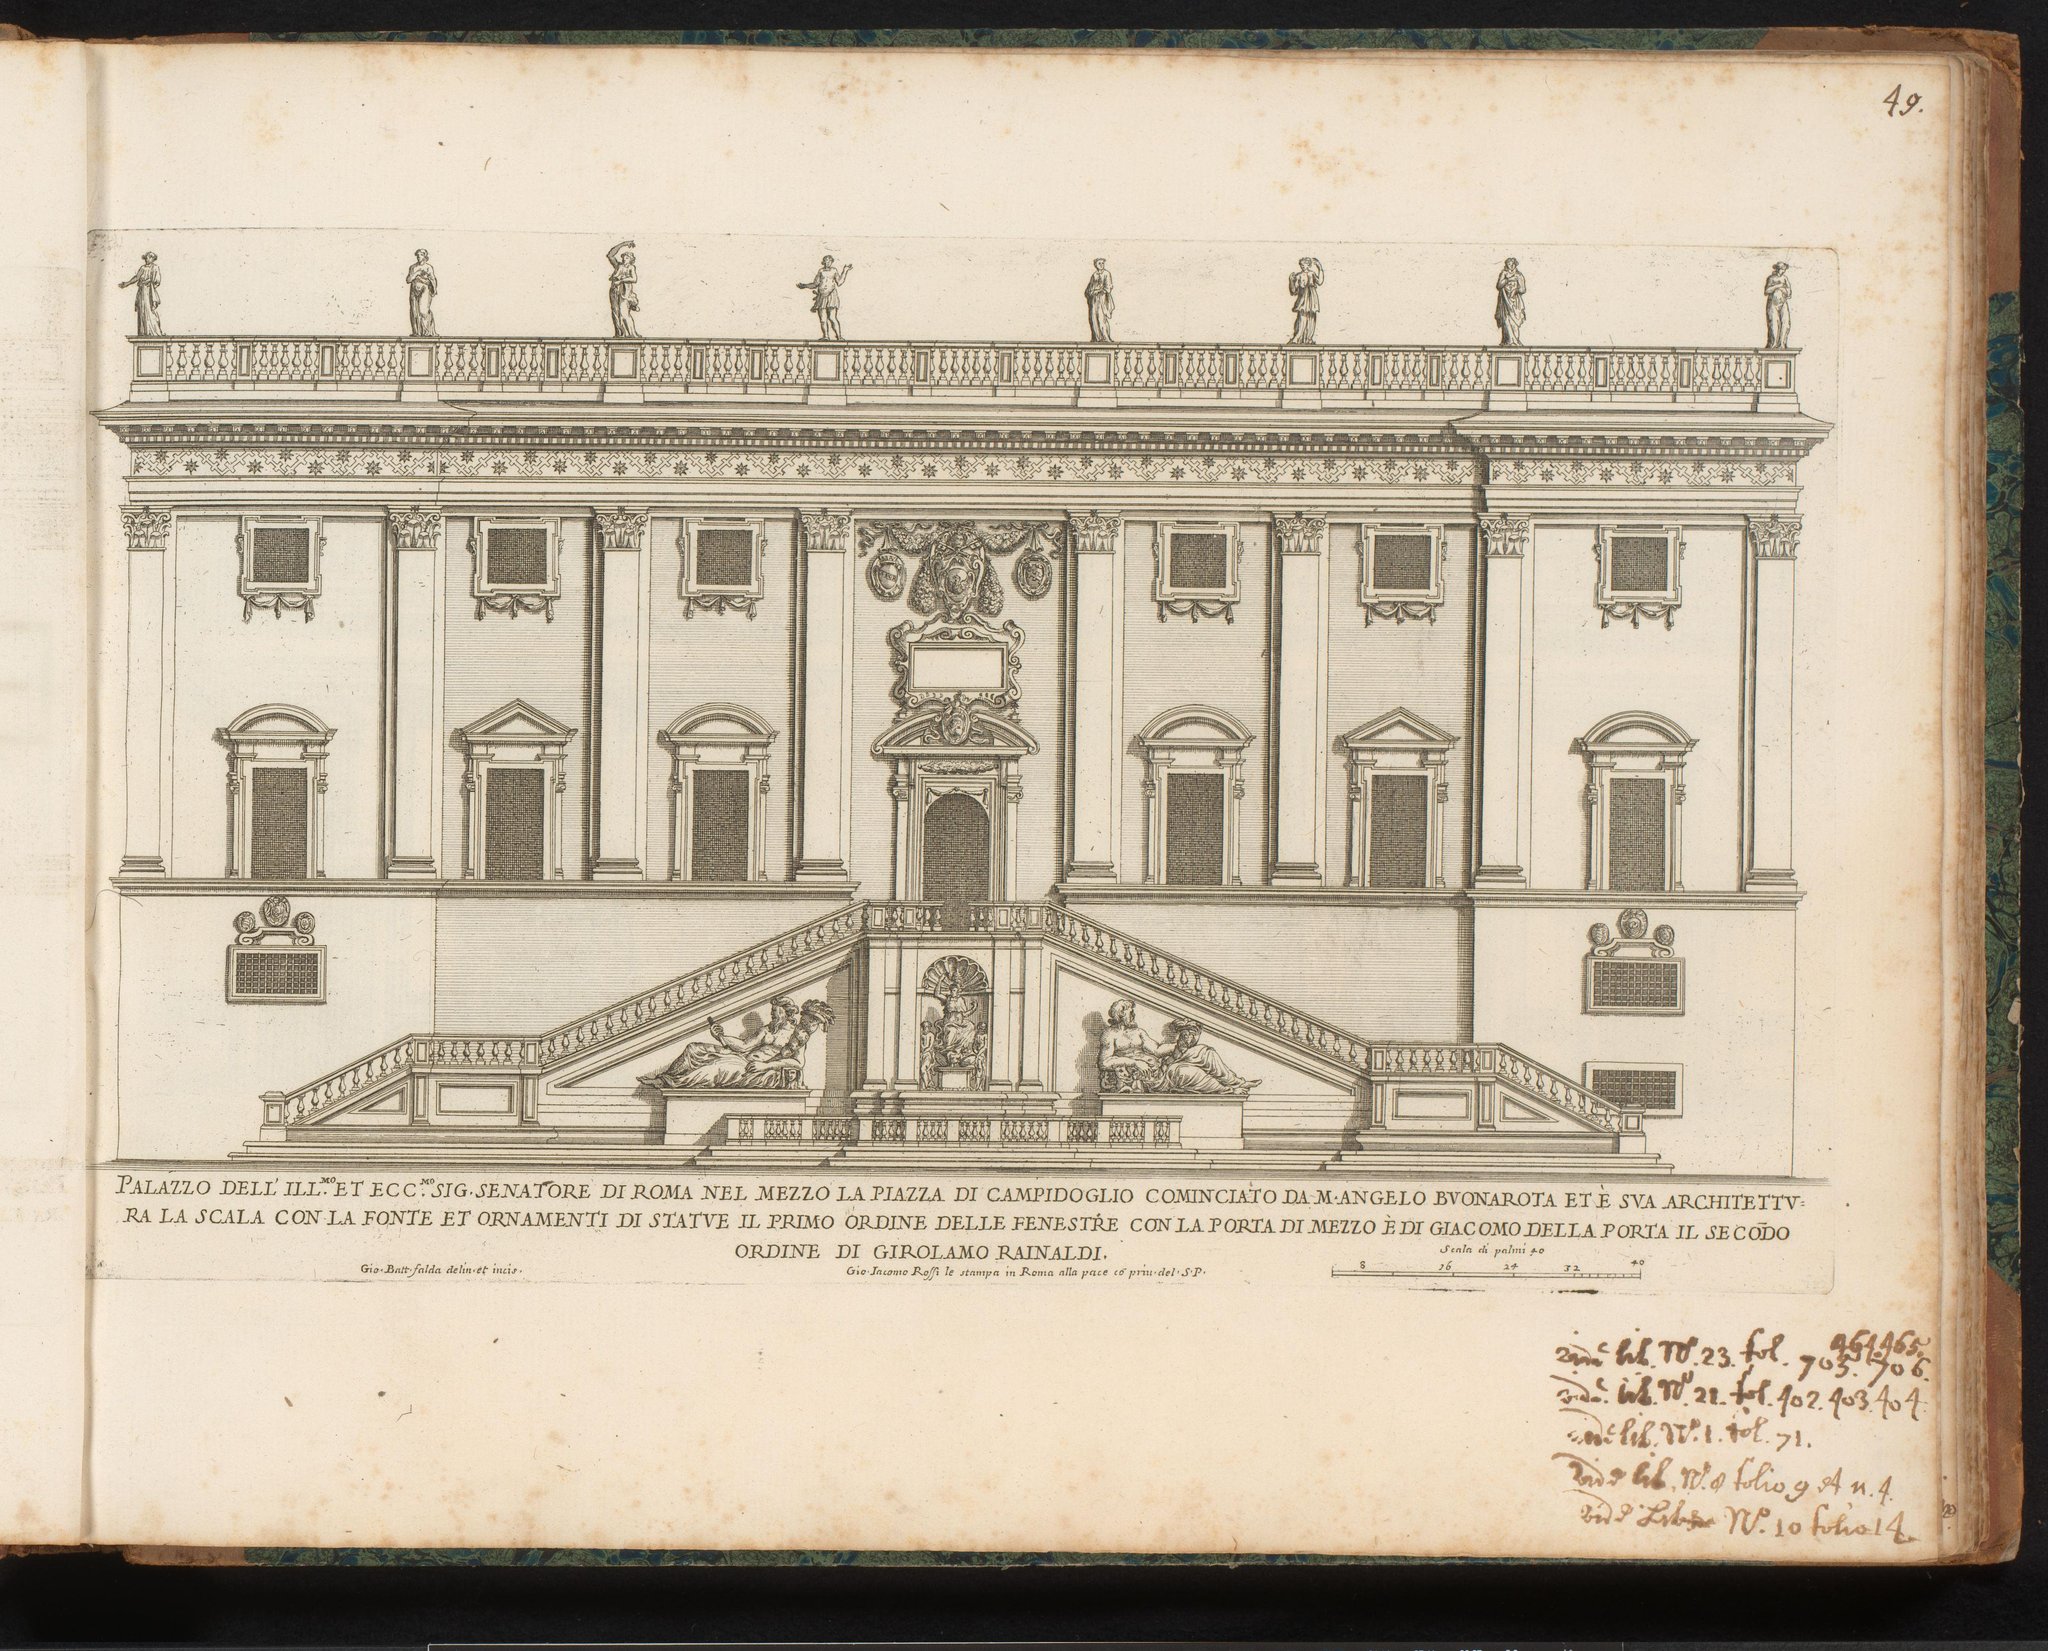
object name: album leaf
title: Façade van Palazzo Senatorio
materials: paper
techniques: etching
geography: rome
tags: palace, façade (of house or building)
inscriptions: inscription: ‘Ende lib. No. 23. fol. 703. 464. 465. 706./ Ende lib. No. 21. fol. 402. 403. 404./ Ende lib. No. 1. fol. 71...’, number: ‘49’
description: Deze prent maakt deel uit van de reeks getiteld: Palazzi di Roma. Deze reeks bestaat uit twee boeken. Boek één getiteld: Palazzi di Roma dei più celebri architetti..., bestaat uit 44 prenten die worden toegeschreven aan Giovanni Battista Falda (naam staat enkel op prent 27) en uitgegeven door Giovanni Giacomo de'Rossi. Deze 44 prenten zijn bekend in twee staten (met en zonder nummer). Boek twee getiteld: Nuovi disegni dell'architetture... libro secondo, bevat 66 prenten door Giovanni Battista Falda en Simone Felice. Deze 66 prenten zijn bekend in twee staten (met en zonder nummer).